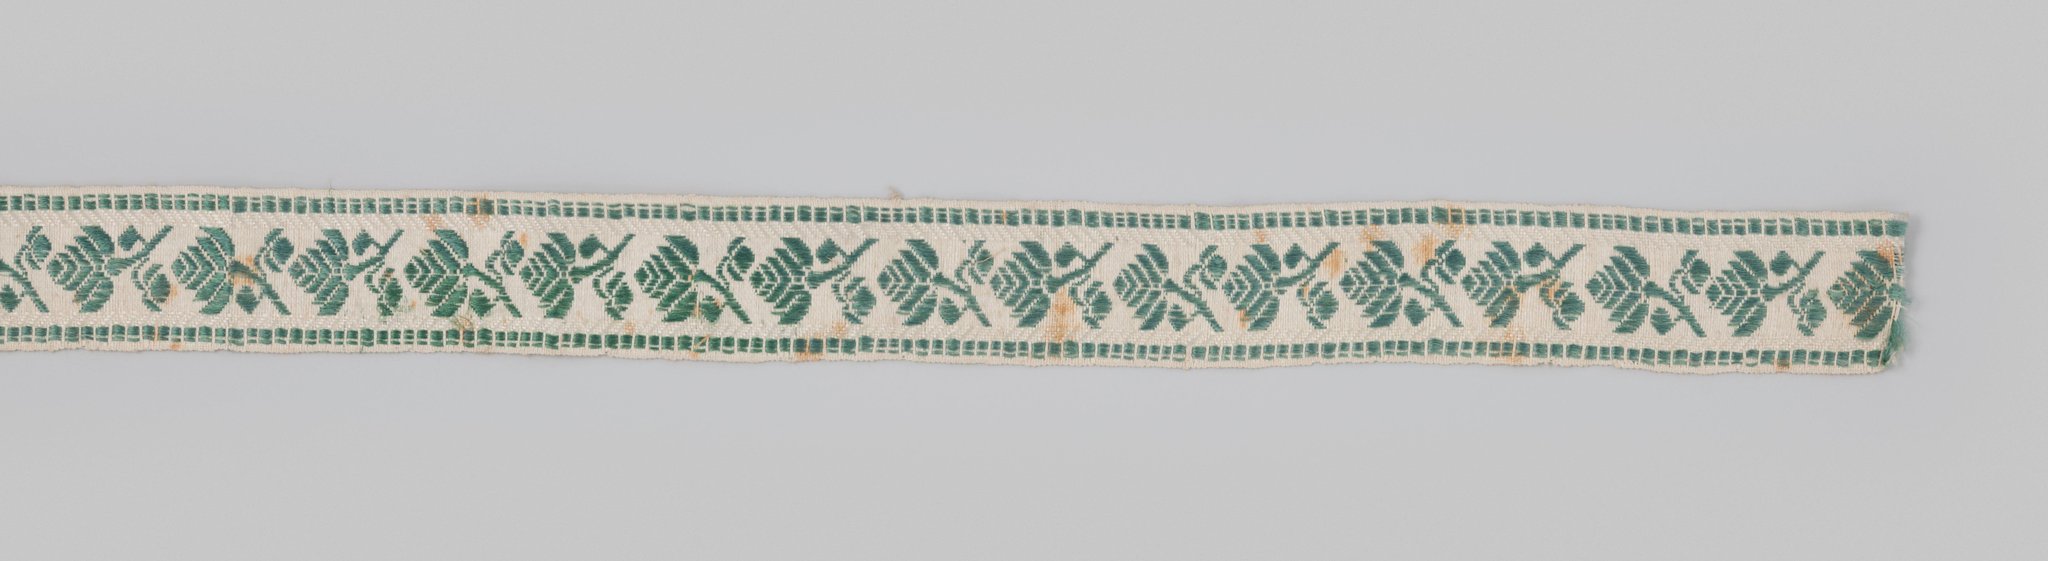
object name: clothing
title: Lint, linnen inslag met bloemen van groene zijde en witte zijden randen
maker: Anonymous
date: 1700-1800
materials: linen, silk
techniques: weave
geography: western europe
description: Lint, linnen inslag met bloemen van groene zijde en wit zijden randen.